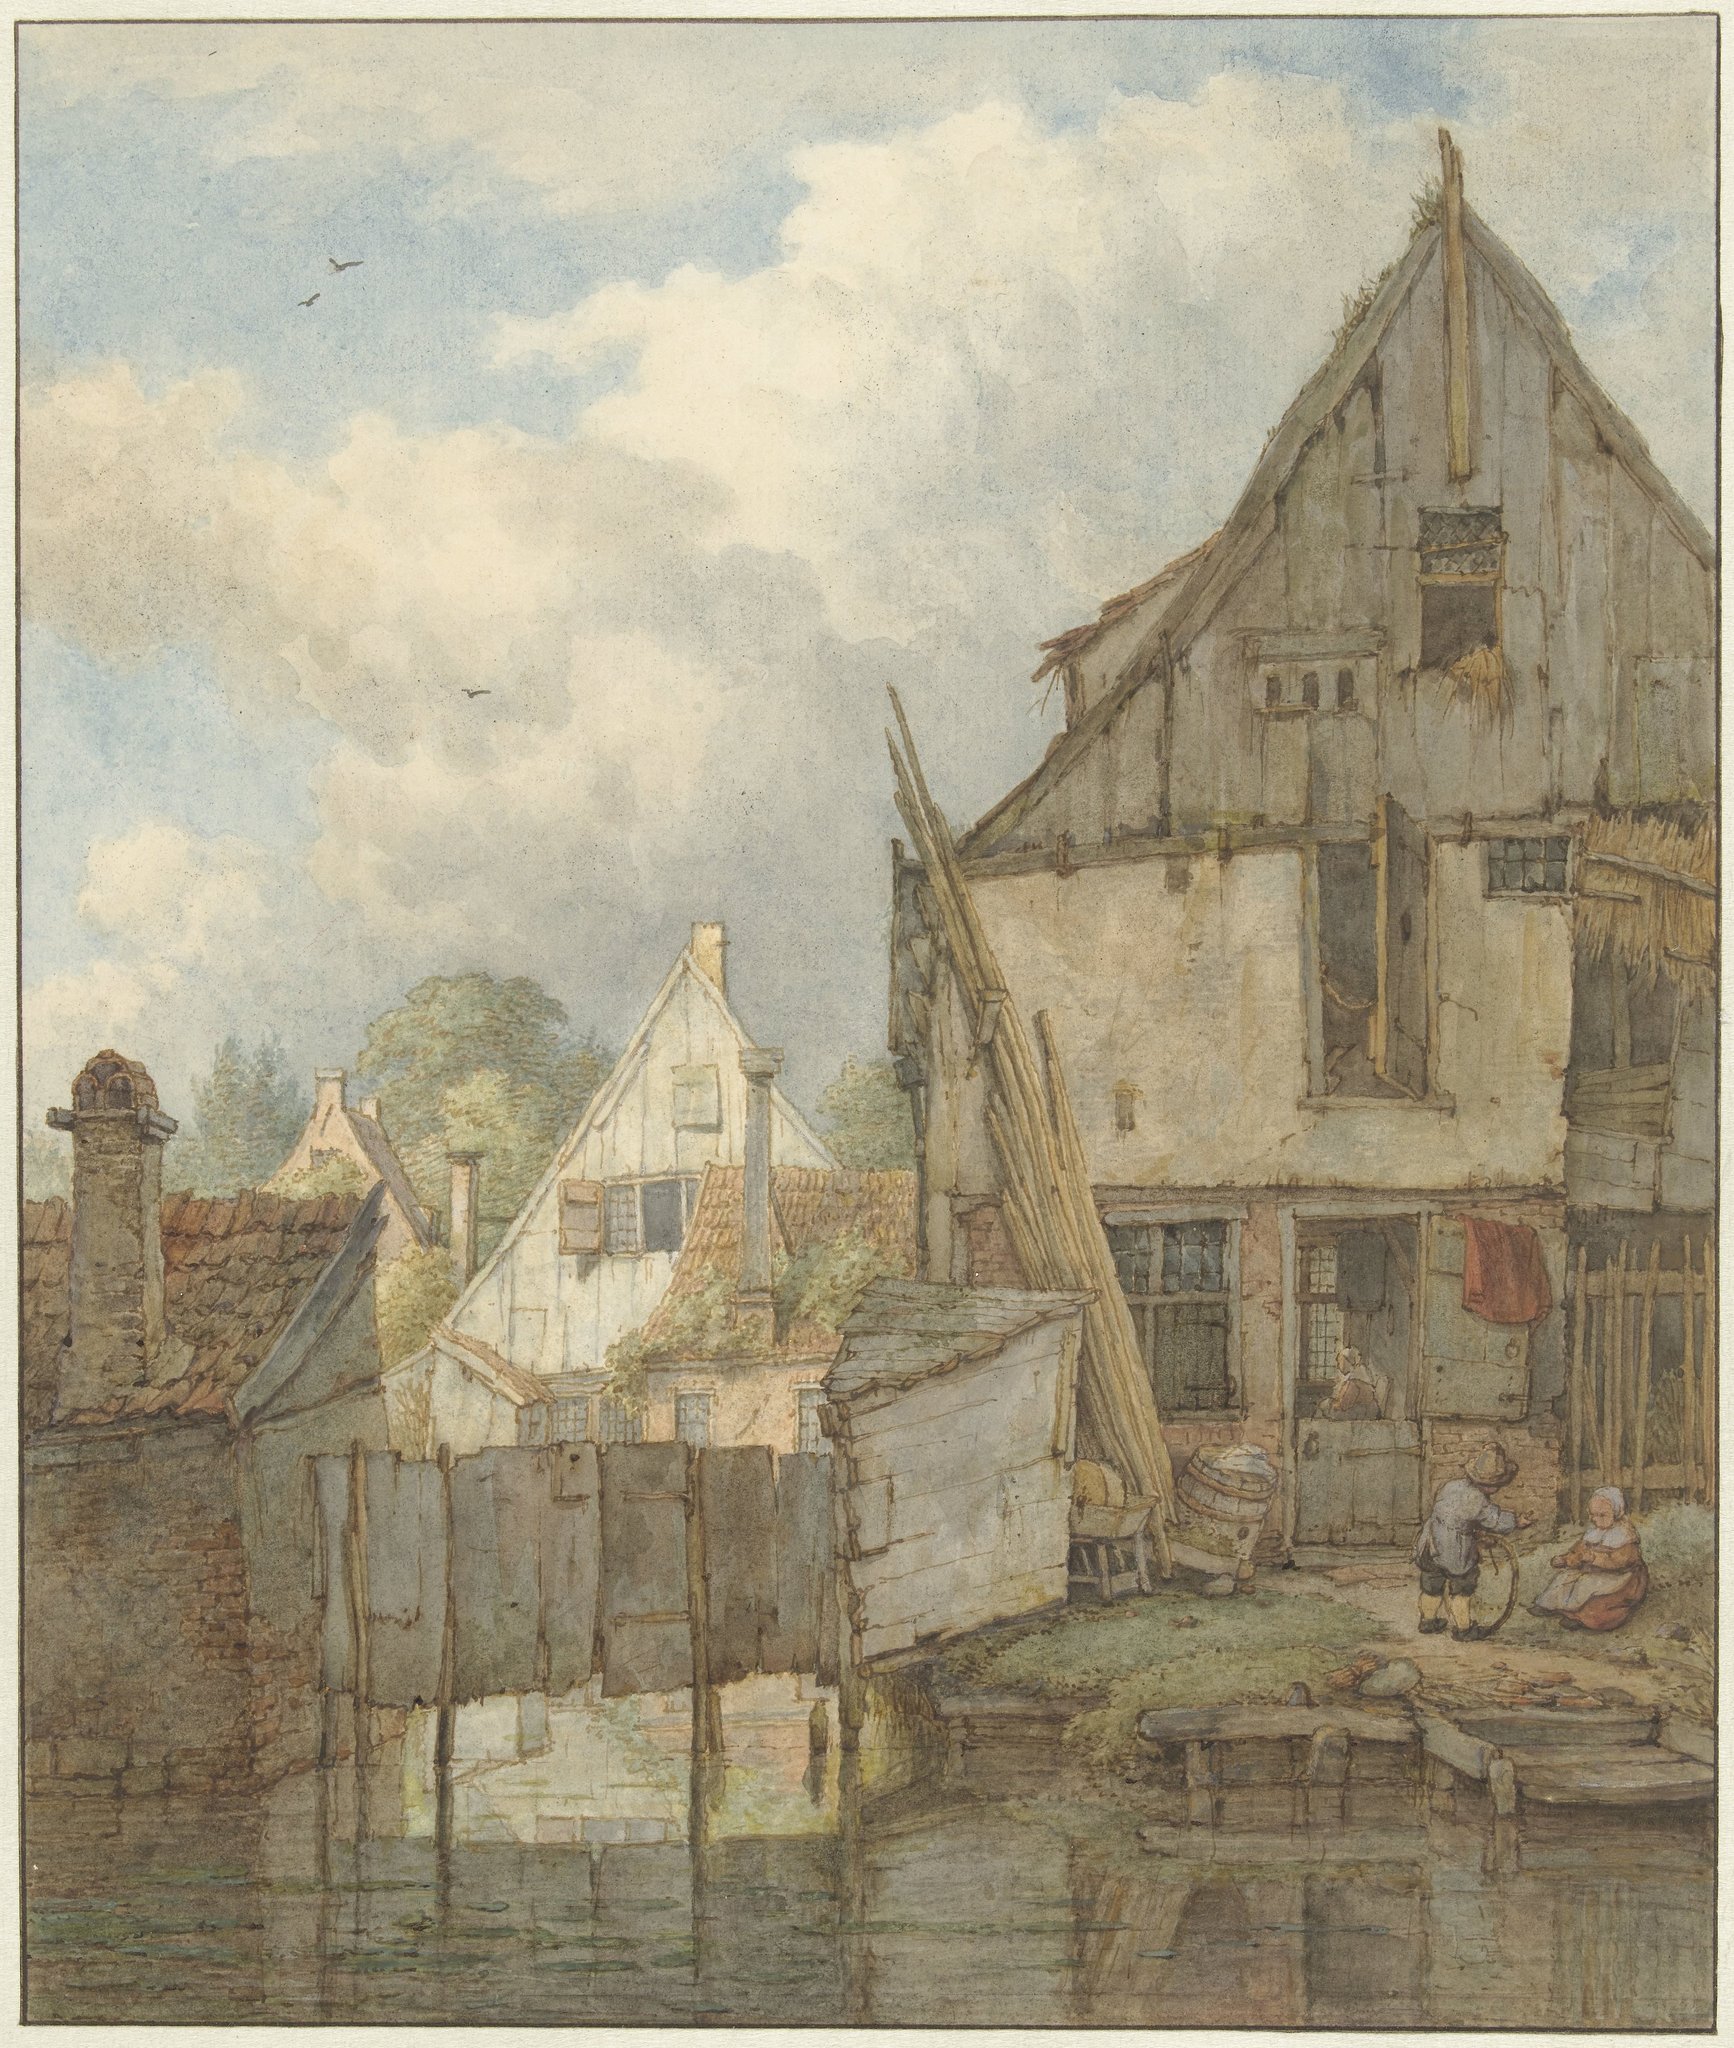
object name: drawing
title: Vervallen huizen aan het water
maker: jan hulswit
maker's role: draughtsman, painter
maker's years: 1766-1822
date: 1776-1822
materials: ink, paper, watercolor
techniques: brush, pen